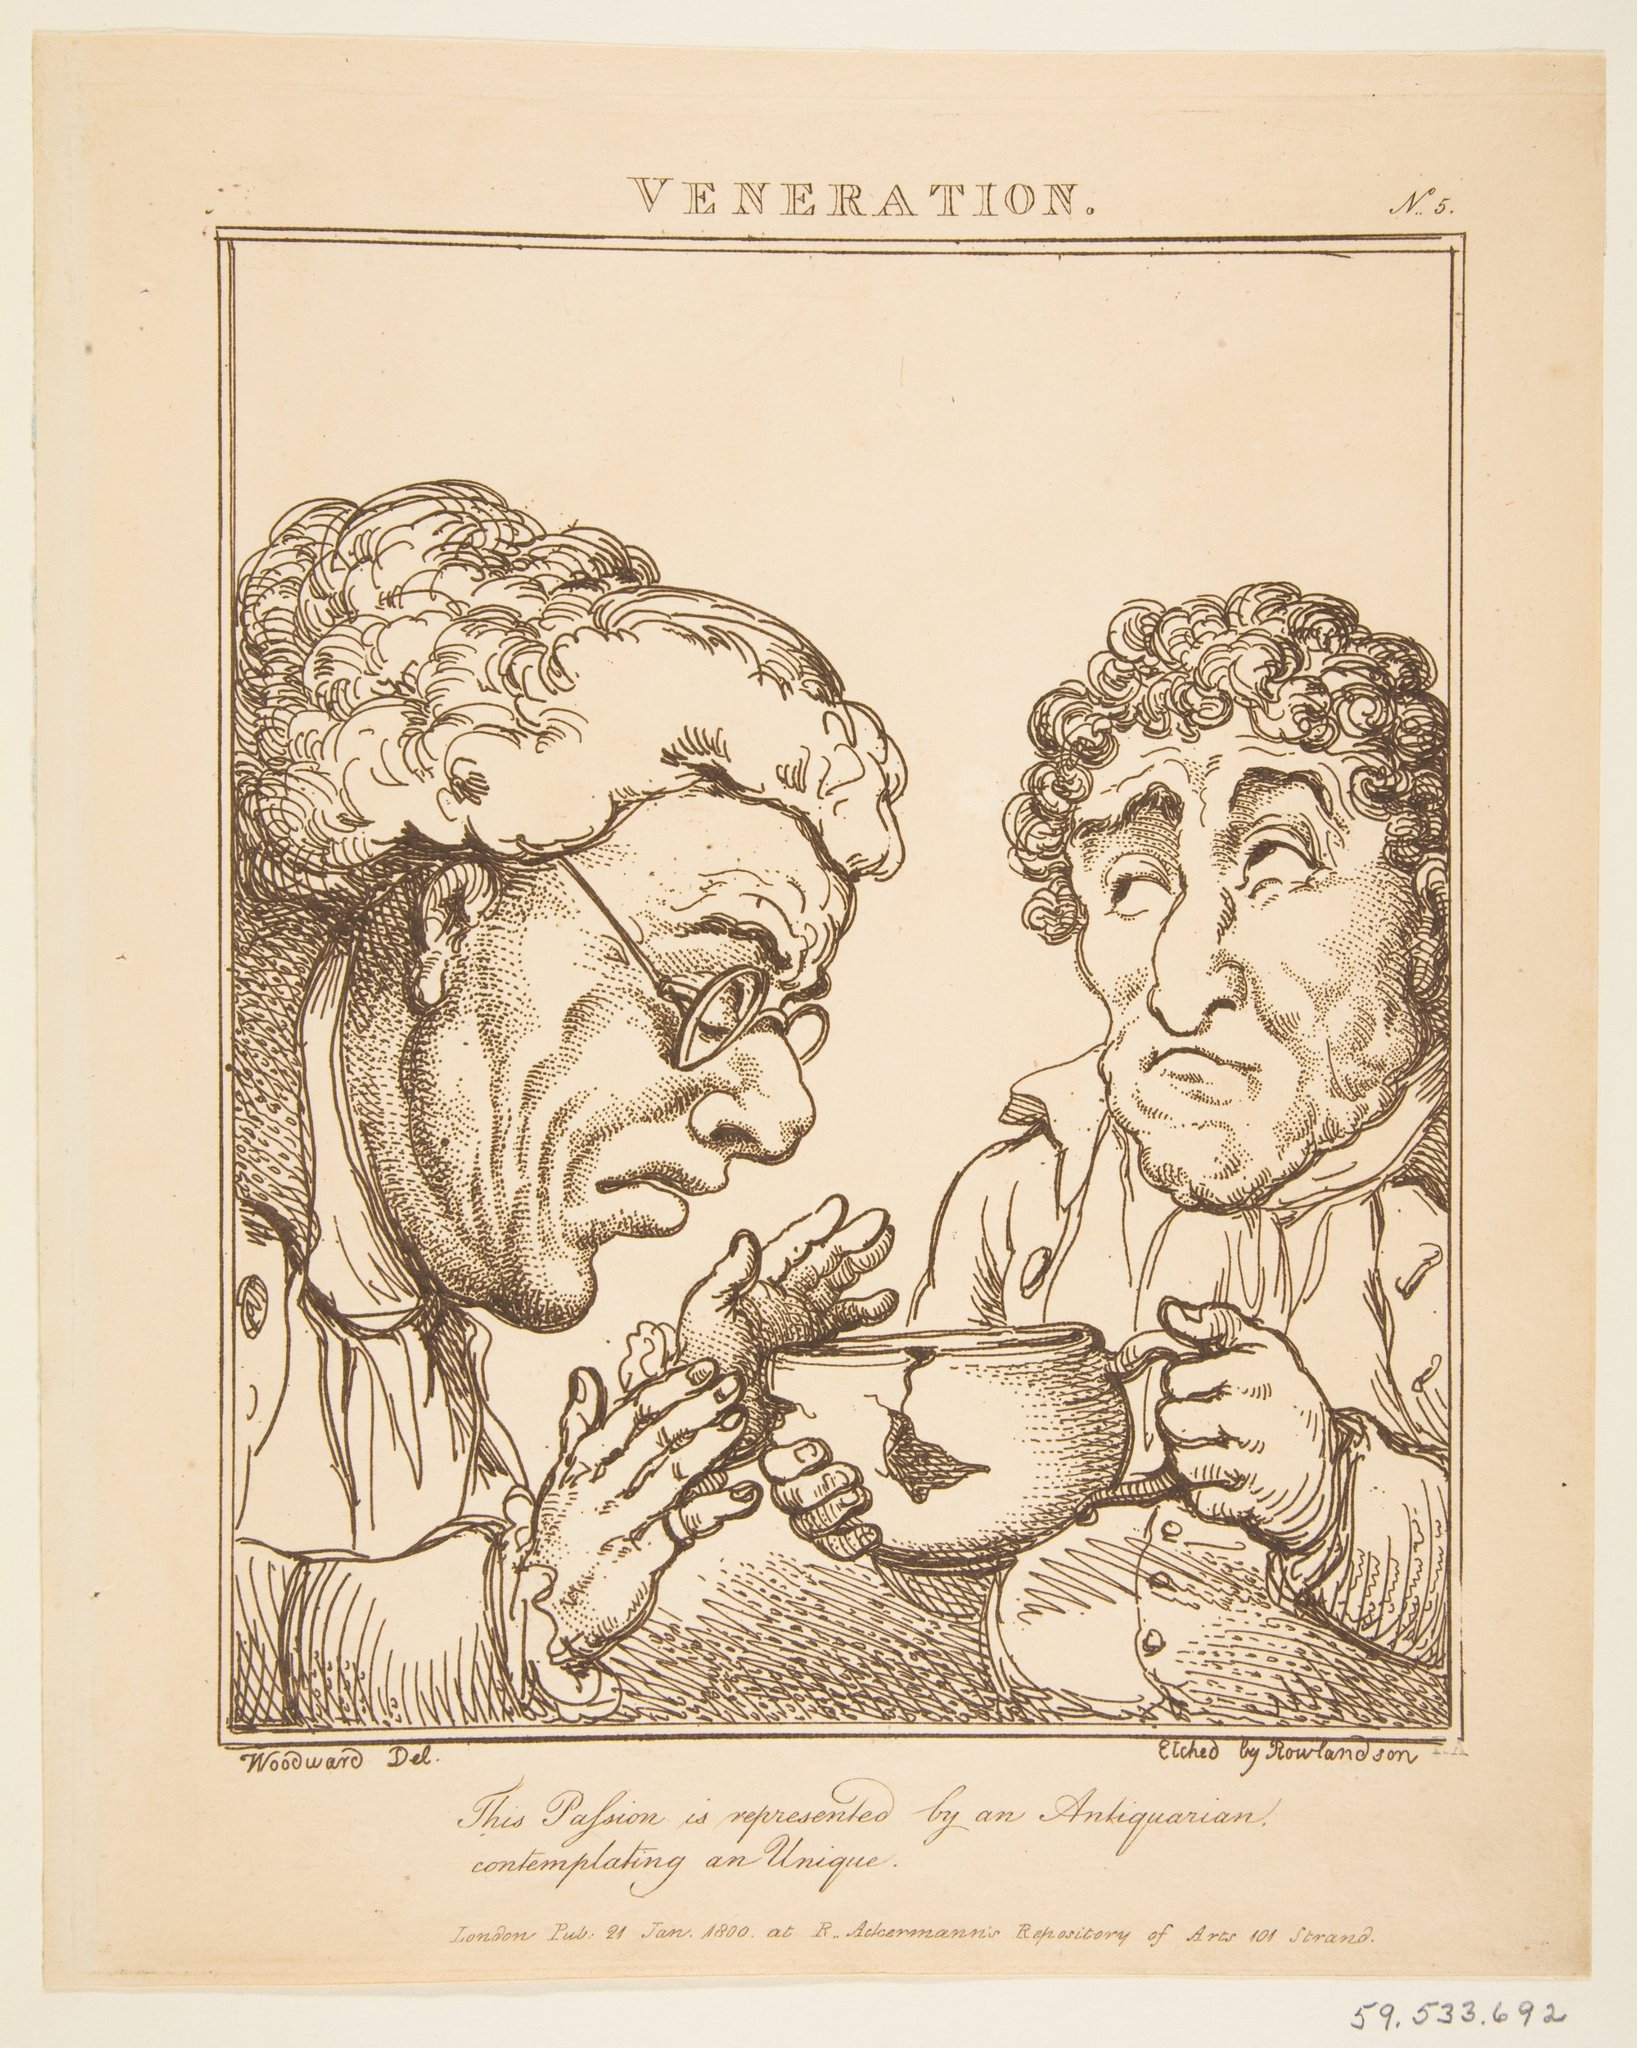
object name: print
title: Veneration (Le Brun Travested, or Caricatures of the Passions)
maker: thomas rowlandson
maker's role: artist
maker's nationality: british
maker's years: 1757-1827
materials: ink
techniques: etching, printing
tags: satire,men